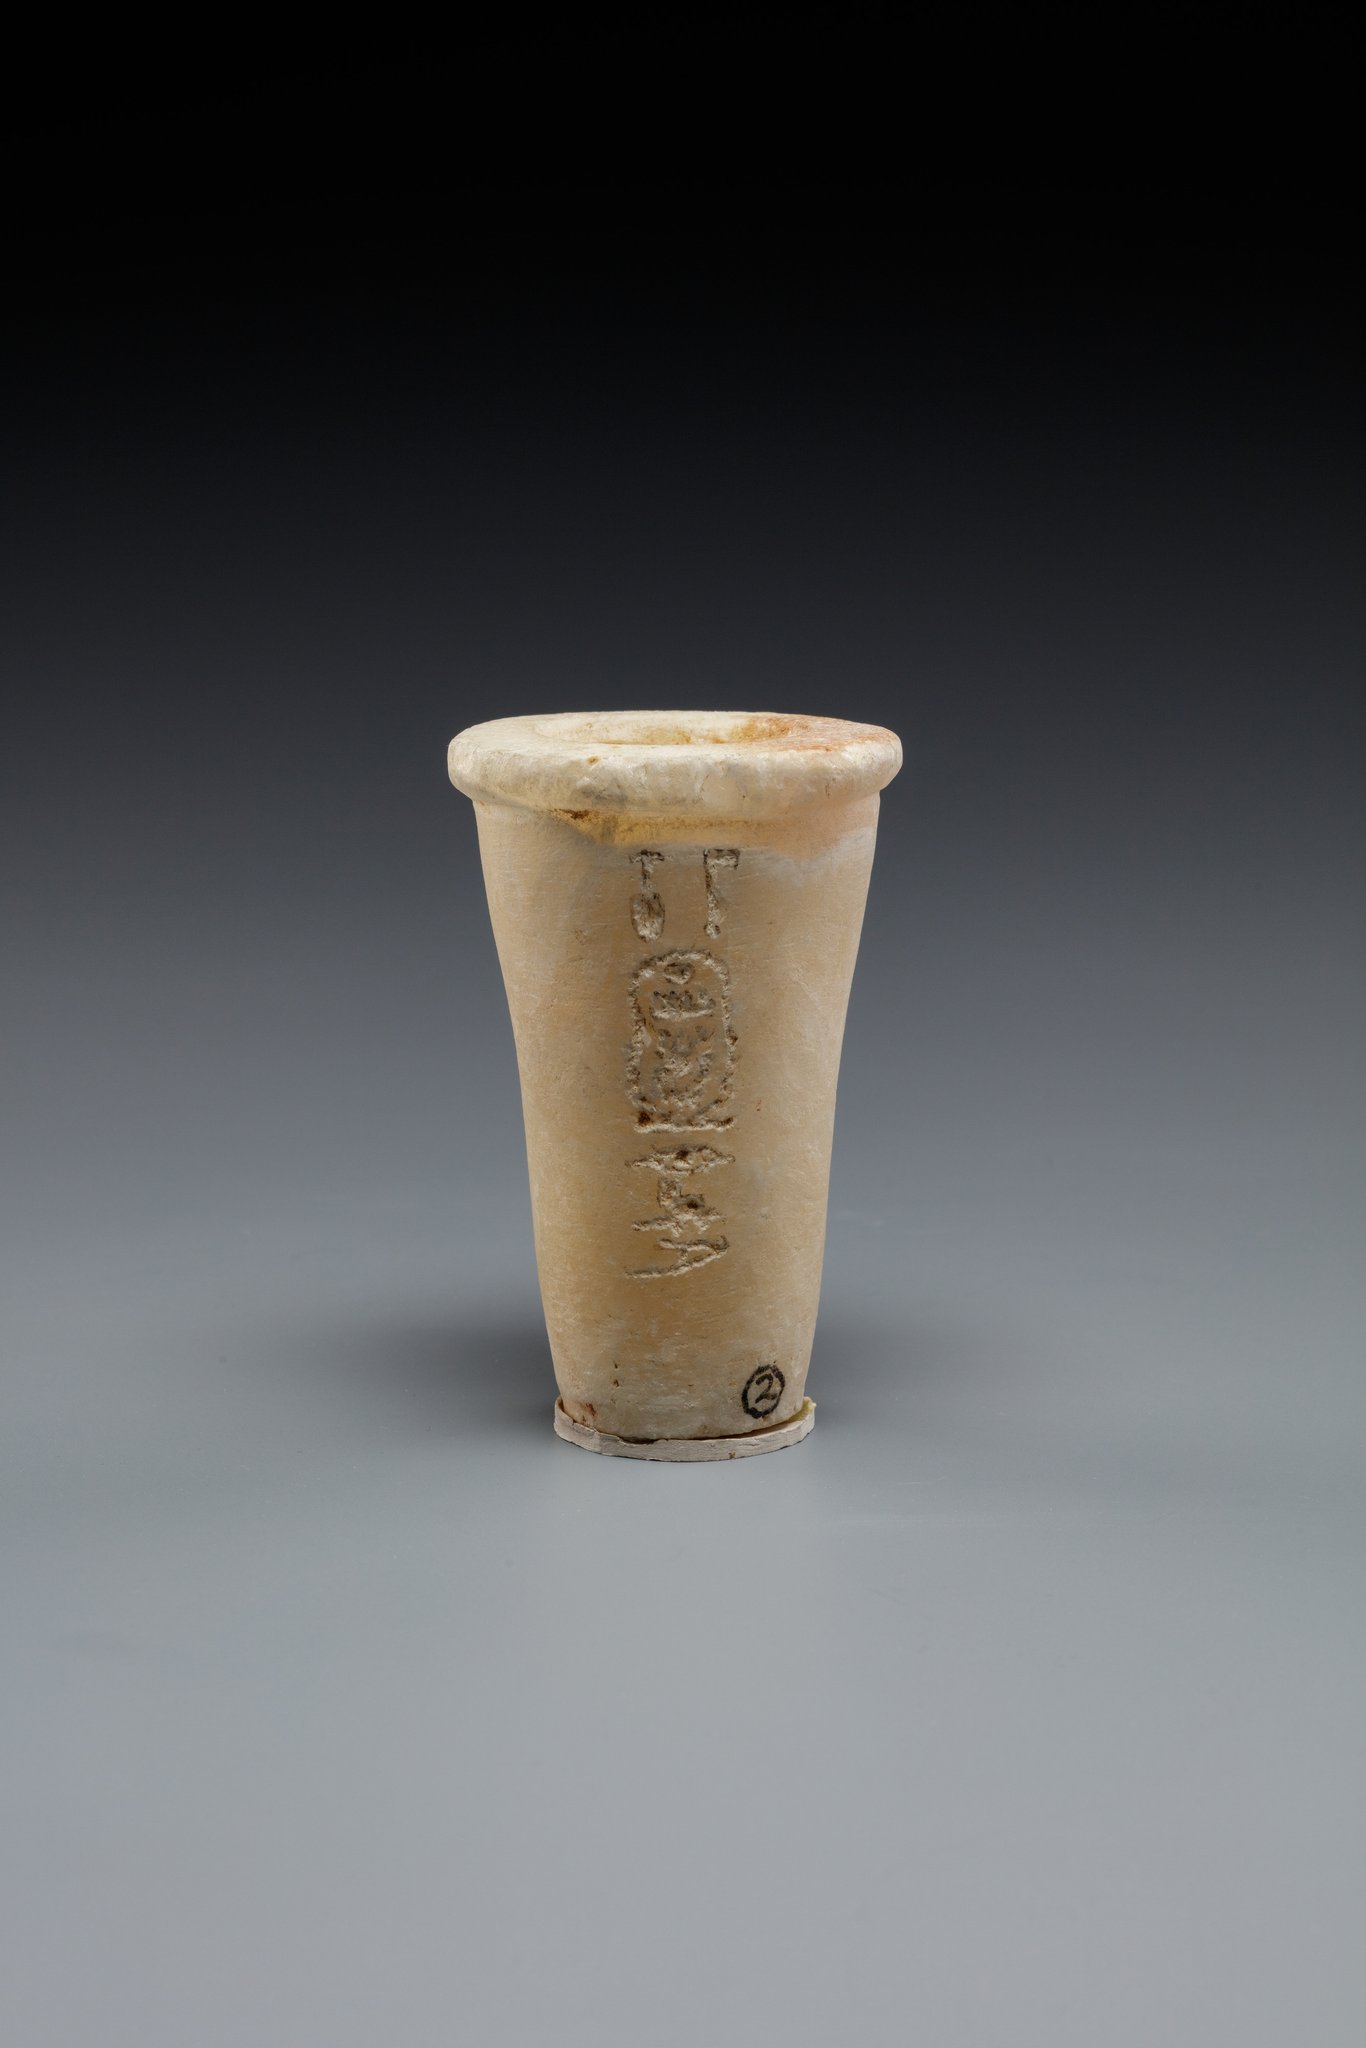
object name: model, vase, thutmose iv, kv 43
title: Model Vase from a Foundation Deposit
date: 1400-1390 BCE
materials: stone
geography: egypt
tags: cartouches,hieroglyphs